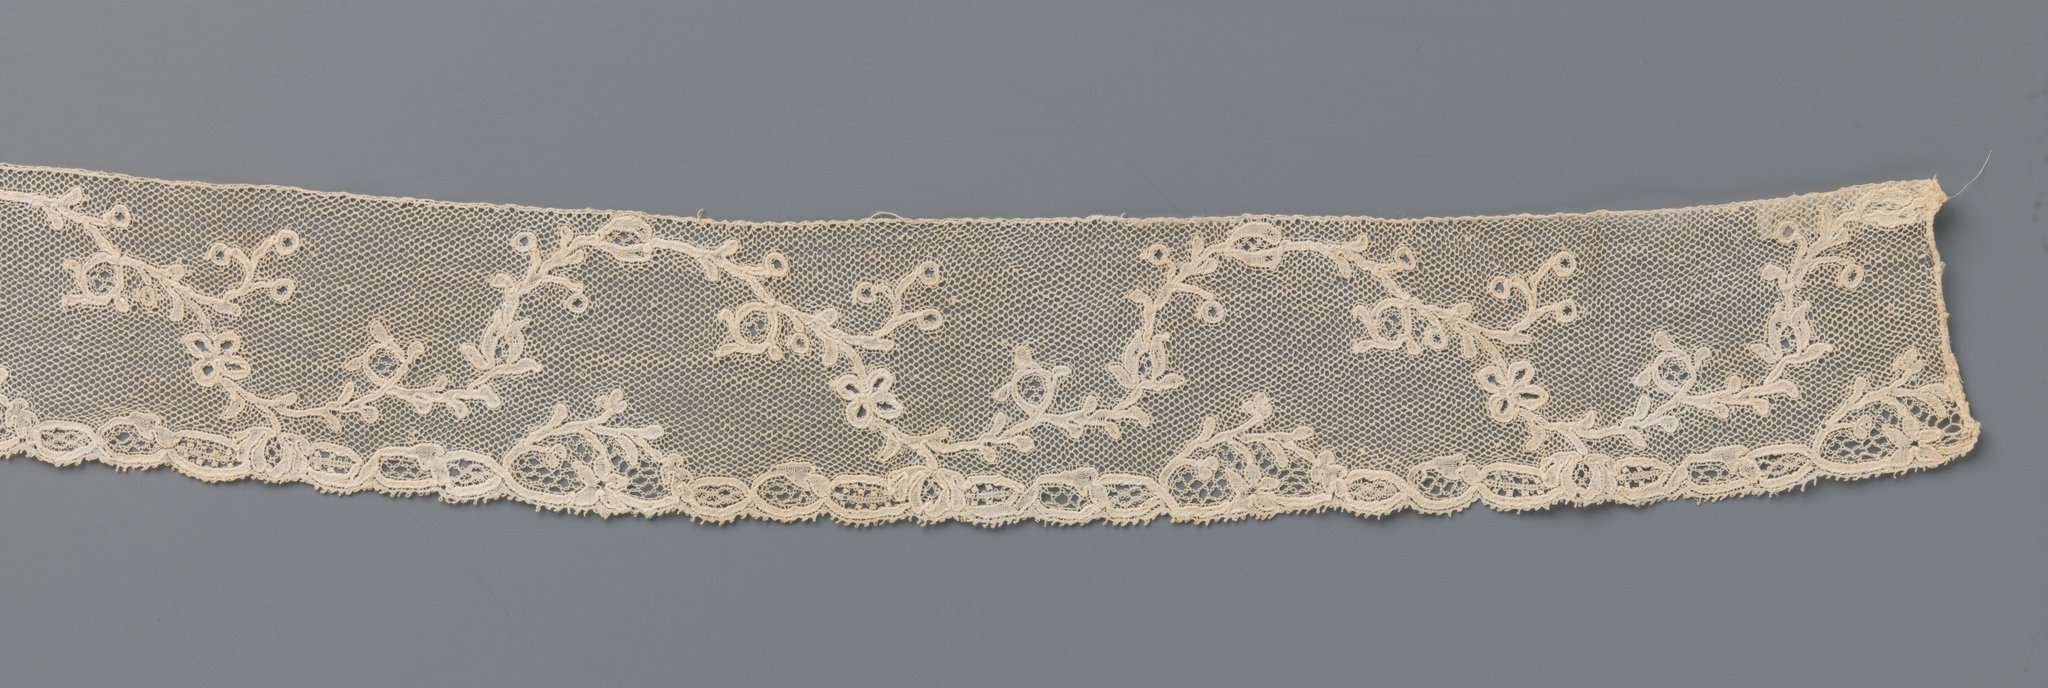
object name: strip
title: Strook kloskant met doorlopende golvende rank met besjes en vlinder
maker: Anonymous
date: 1770-1780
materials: linen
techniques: lace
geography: mechelen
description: Strook naturelkleurige kloskant: Mechelse kant. Het zich herhalende patroon bestaat uit een doorlopende en golvende rank met kleine blaadjes aan weerskanten, een enkele korte aftakking met een besje eraan en enkele bloempjes. Aan het begin van elke golftop zit een vlinder of vlindervormige bloem, de rank maakt binnen één golf twee keer een lusje. De flauw geschulpte onderzijde wordt gevormd door een dubbele smalle slinger, die een aaneenschakeling van spitsovaalvormige cartouches vormt. Onder elke golftop bevindt zich steeds een grotere cartouche in het patroon langs de onderrand, met een bladertakje en een stervormig bloempje. De motieven zijn met elkaar verbonden door een fijne maasgrond, de Mechelse grond. De motieven zijn gemaakt in linnenslag met dikkere en glimmende contourdraden. Er zijn verschillende siergronden toegepast in de cartouches langs de onderzijde, in de lusjes, besjes en bloemharten. De flauw geschulpte onderzijde komt voort uit het patroon met de dubbele slinger en is afgewerkt met picots. De bovenzijde is afgewerkt met een apart geklost recht bandje.